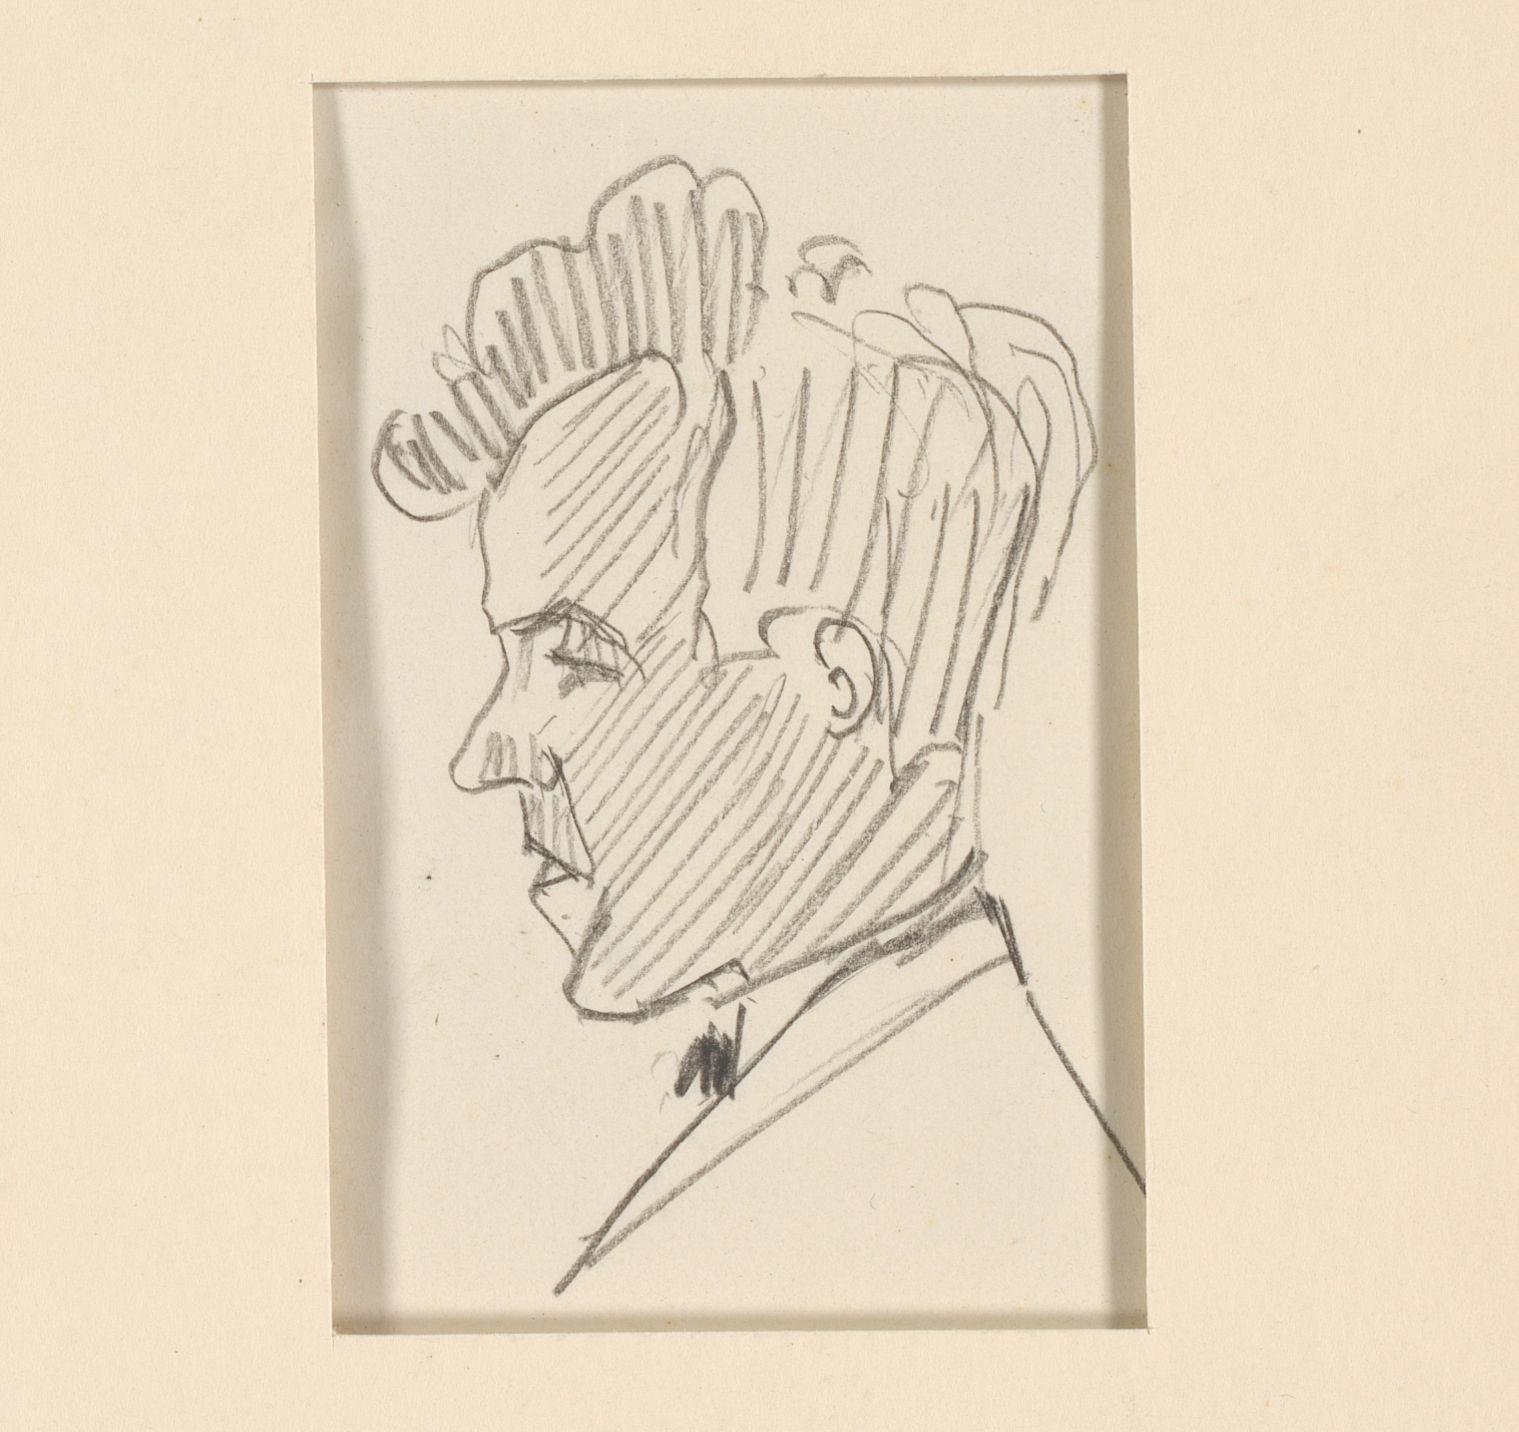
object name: drawing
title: Portret van Leonard Pieter Versteeg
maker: Anonymous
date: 1915-1935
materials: chalk, paper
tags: waalwijk, painter, leonard pieter versteeg, portrait, self-portrait of artist